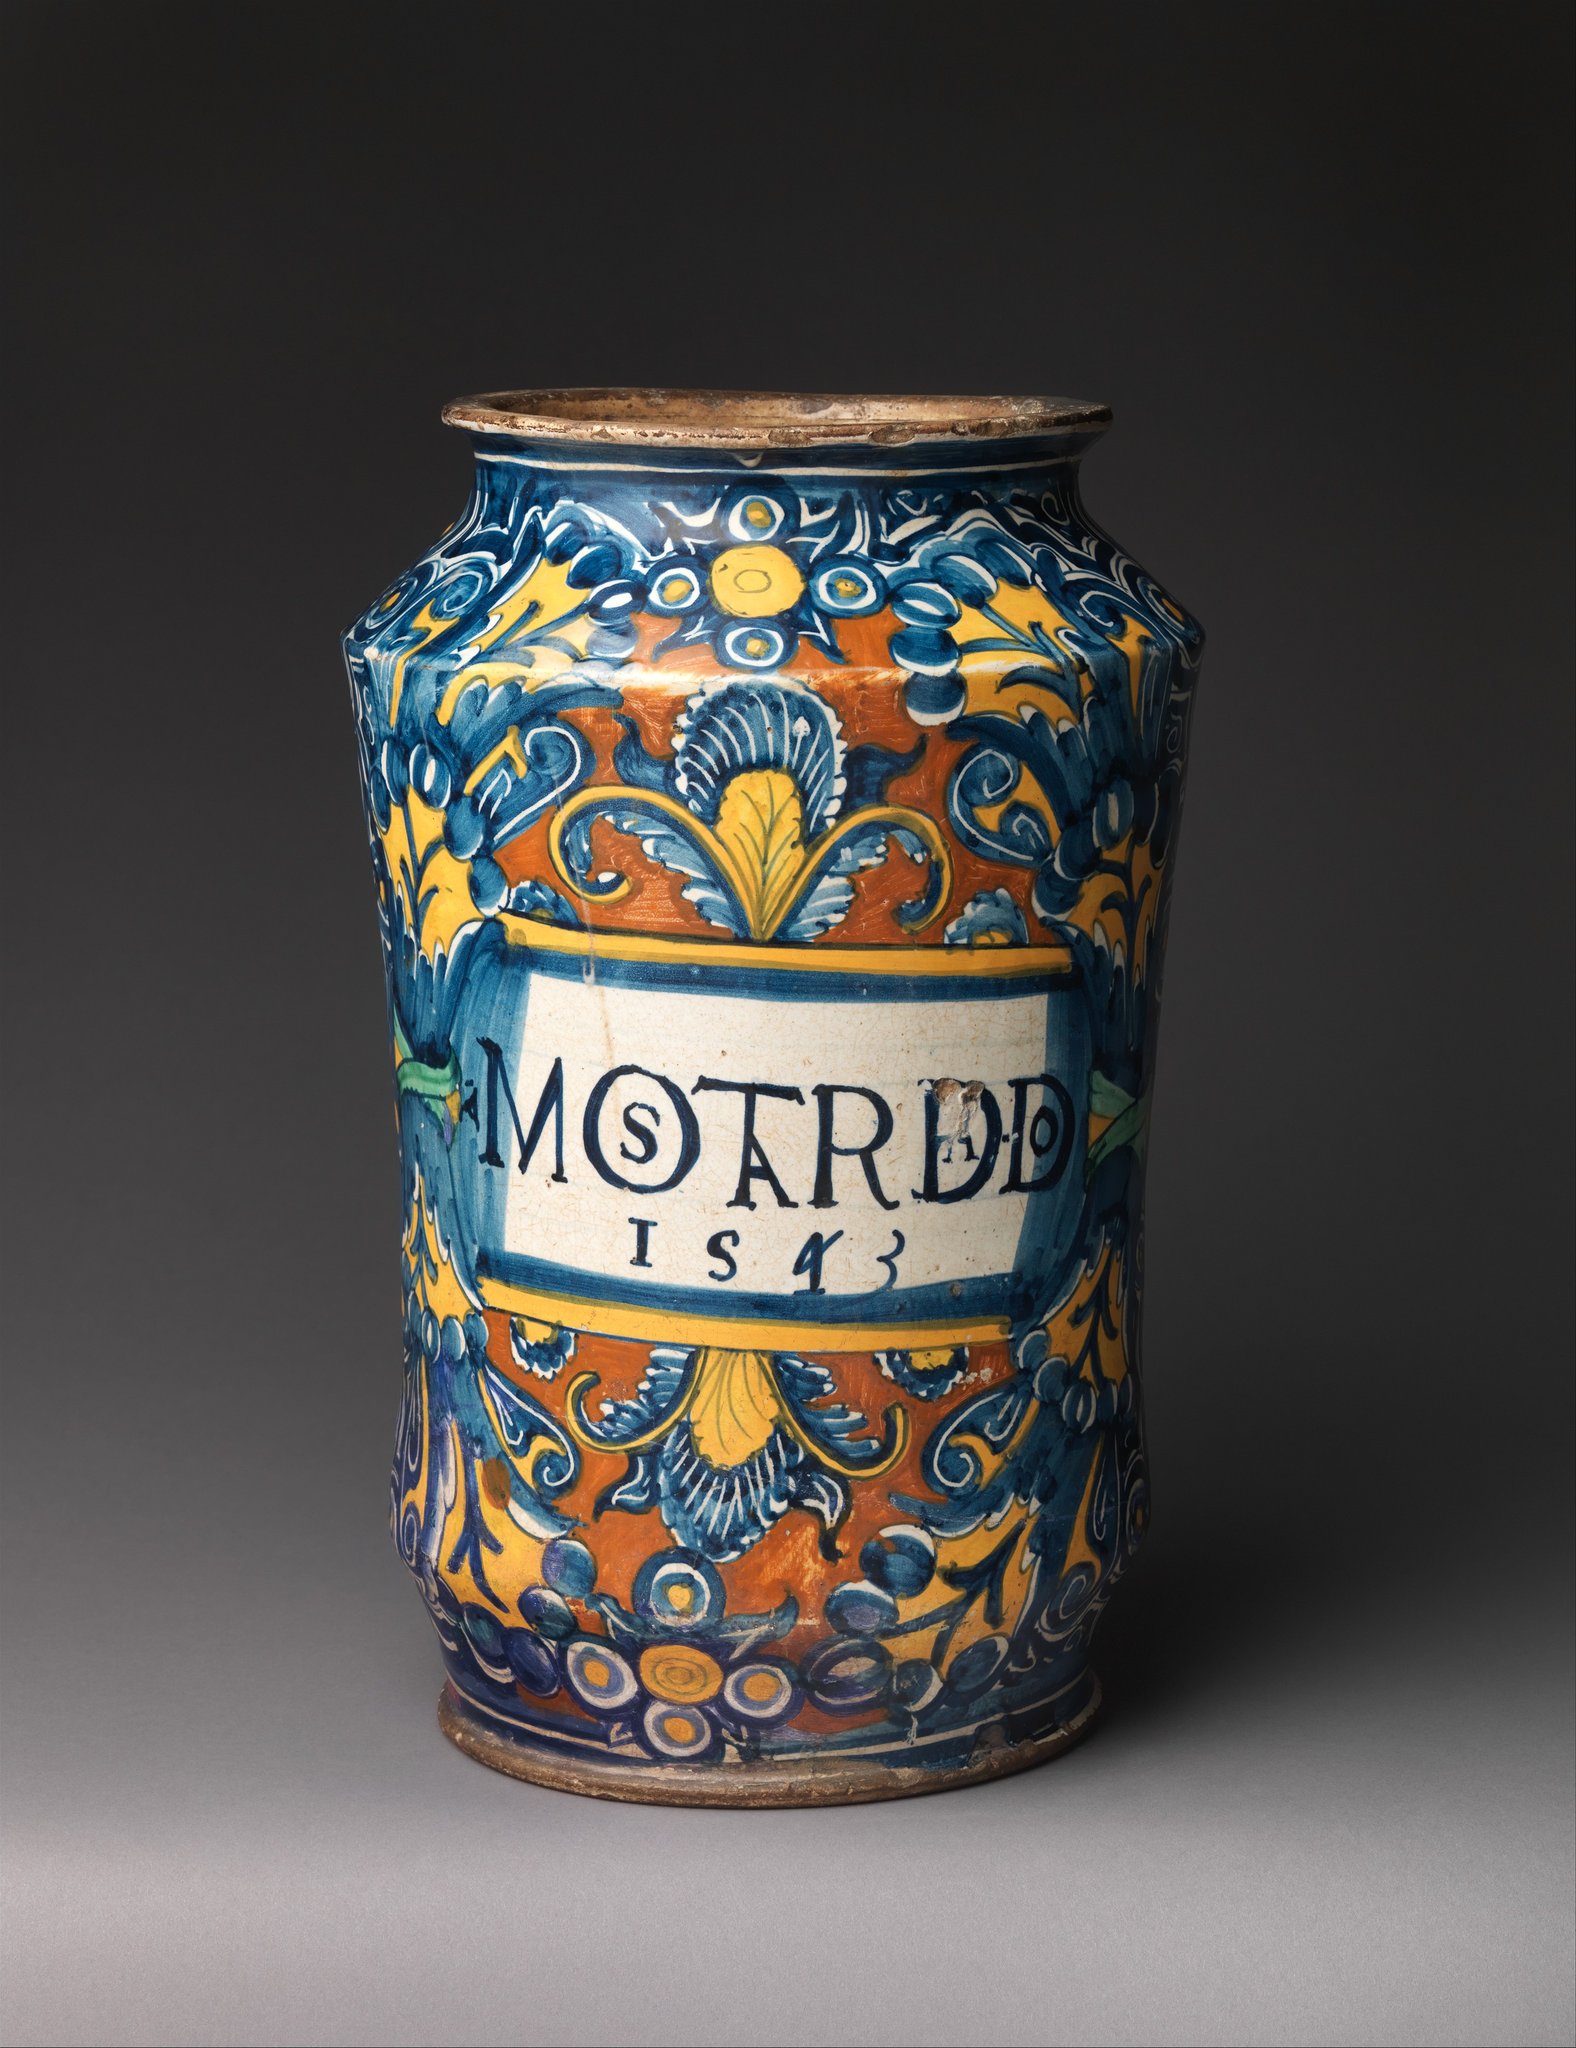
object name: storage jar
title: Storage jar (albarello) for mostarda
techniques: maiolica, glazing